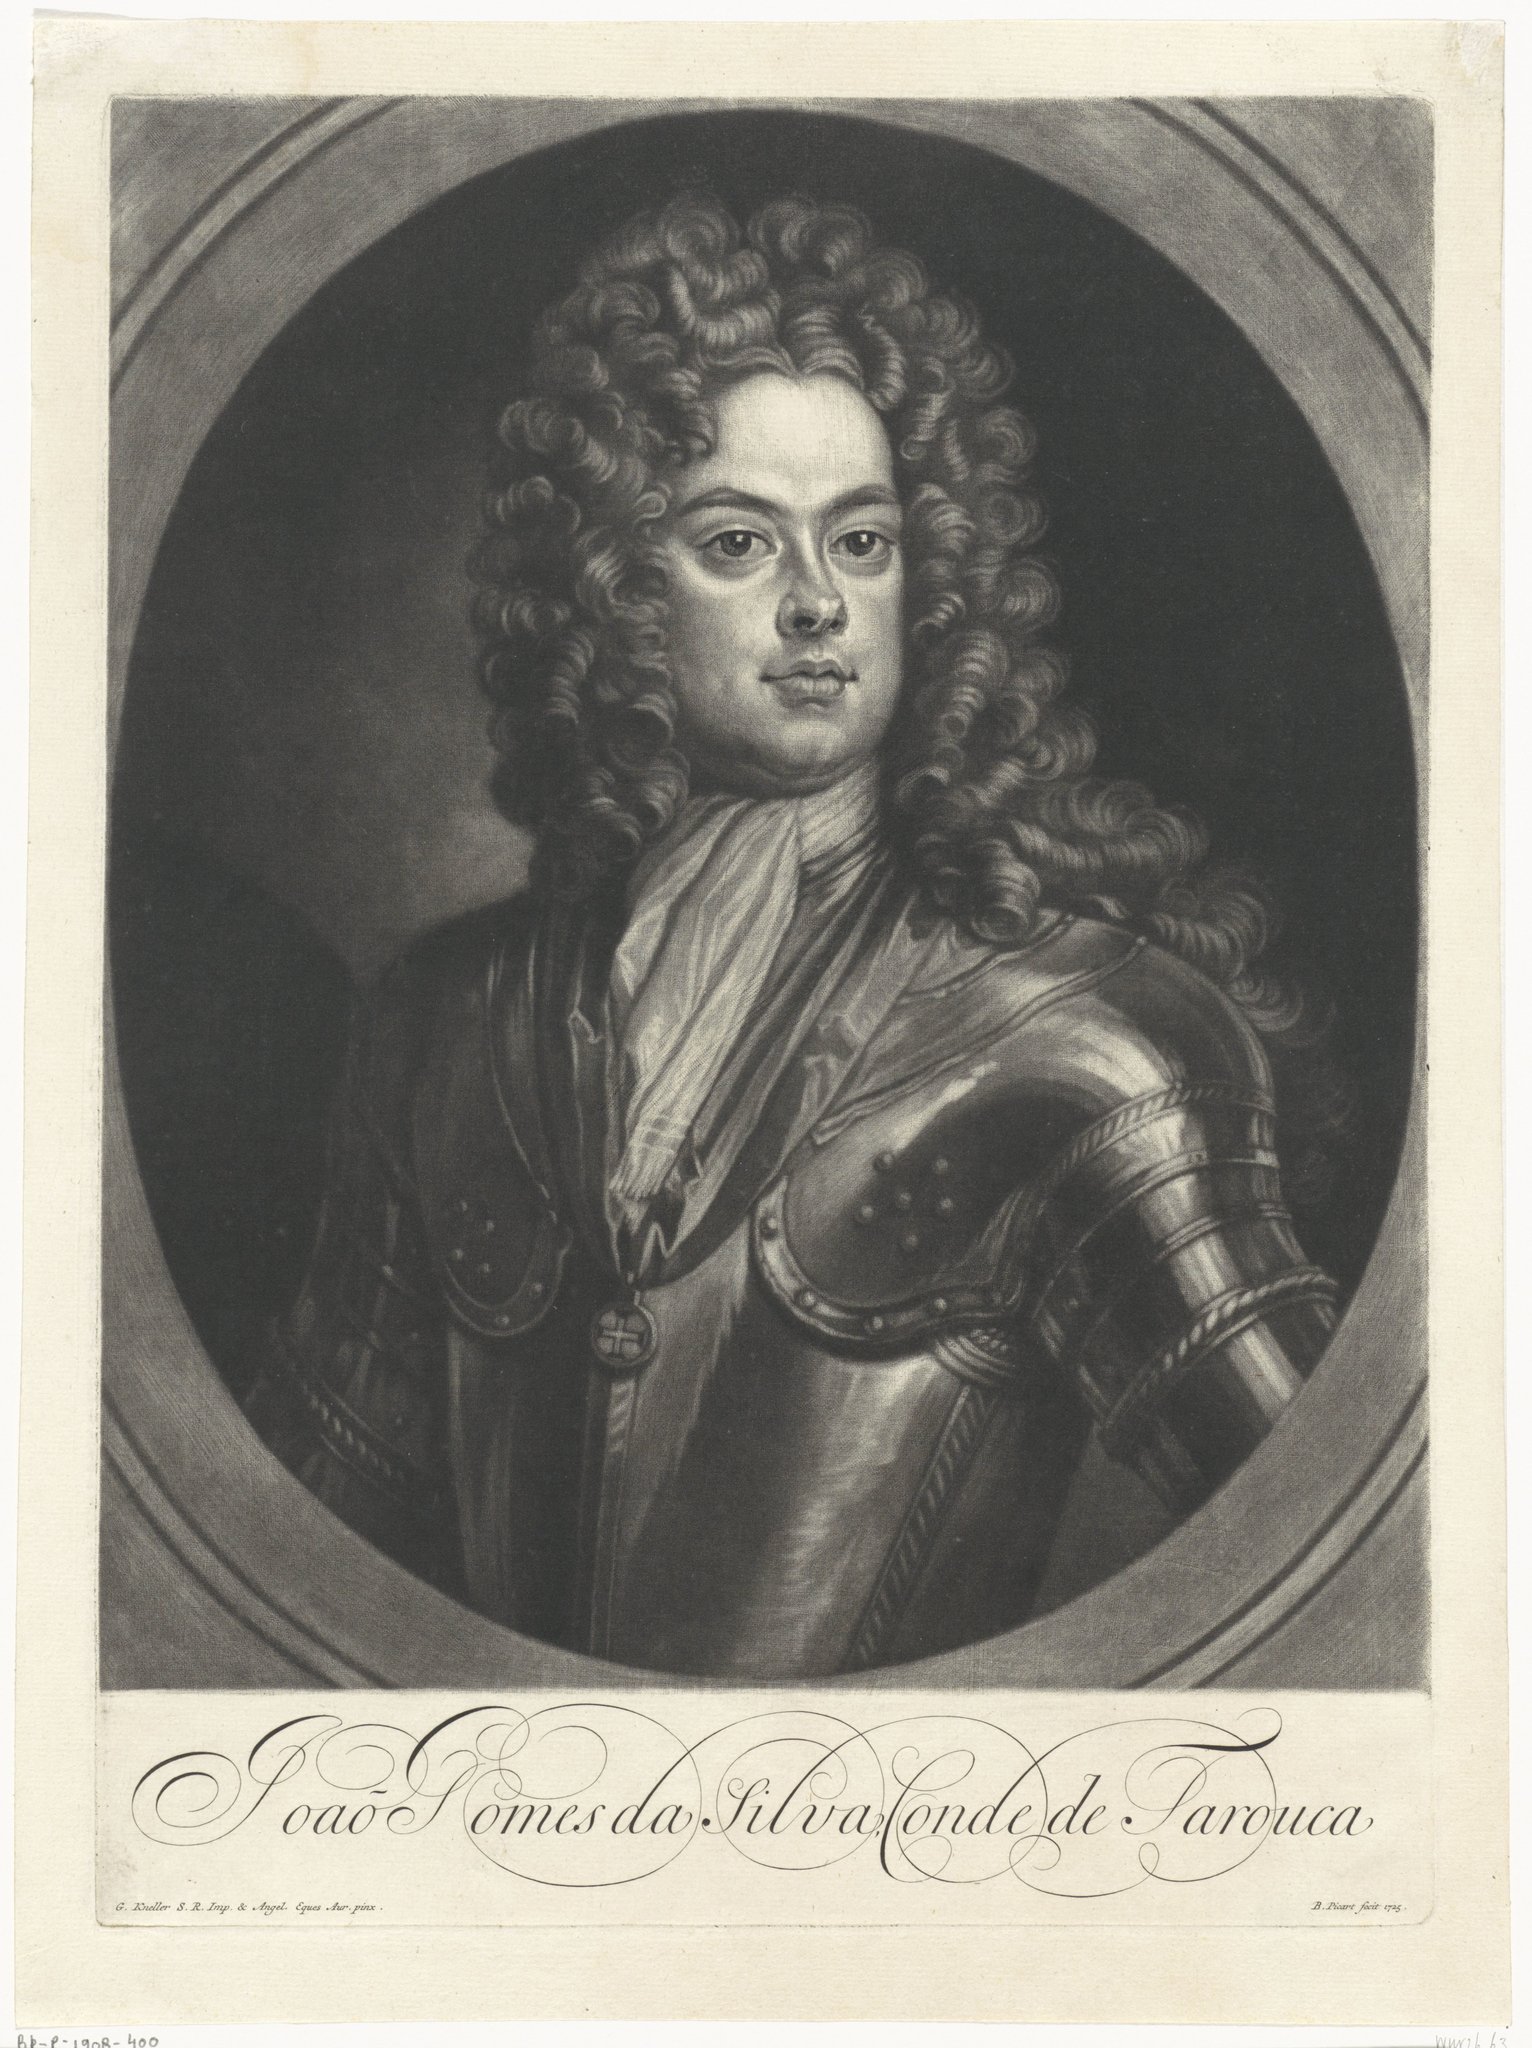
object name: print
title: Portret van Joao Gomes da Silva Conde de Tarouca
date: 1725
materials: paper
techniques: engraving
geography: amsterdam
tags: harness, wig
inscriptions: collector's mark: Lugt 2228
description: De Portugese militair en diplomaat Joan Gomes da Silva, Conde de Tarouca in een harnas. Hij draagt een pruik.